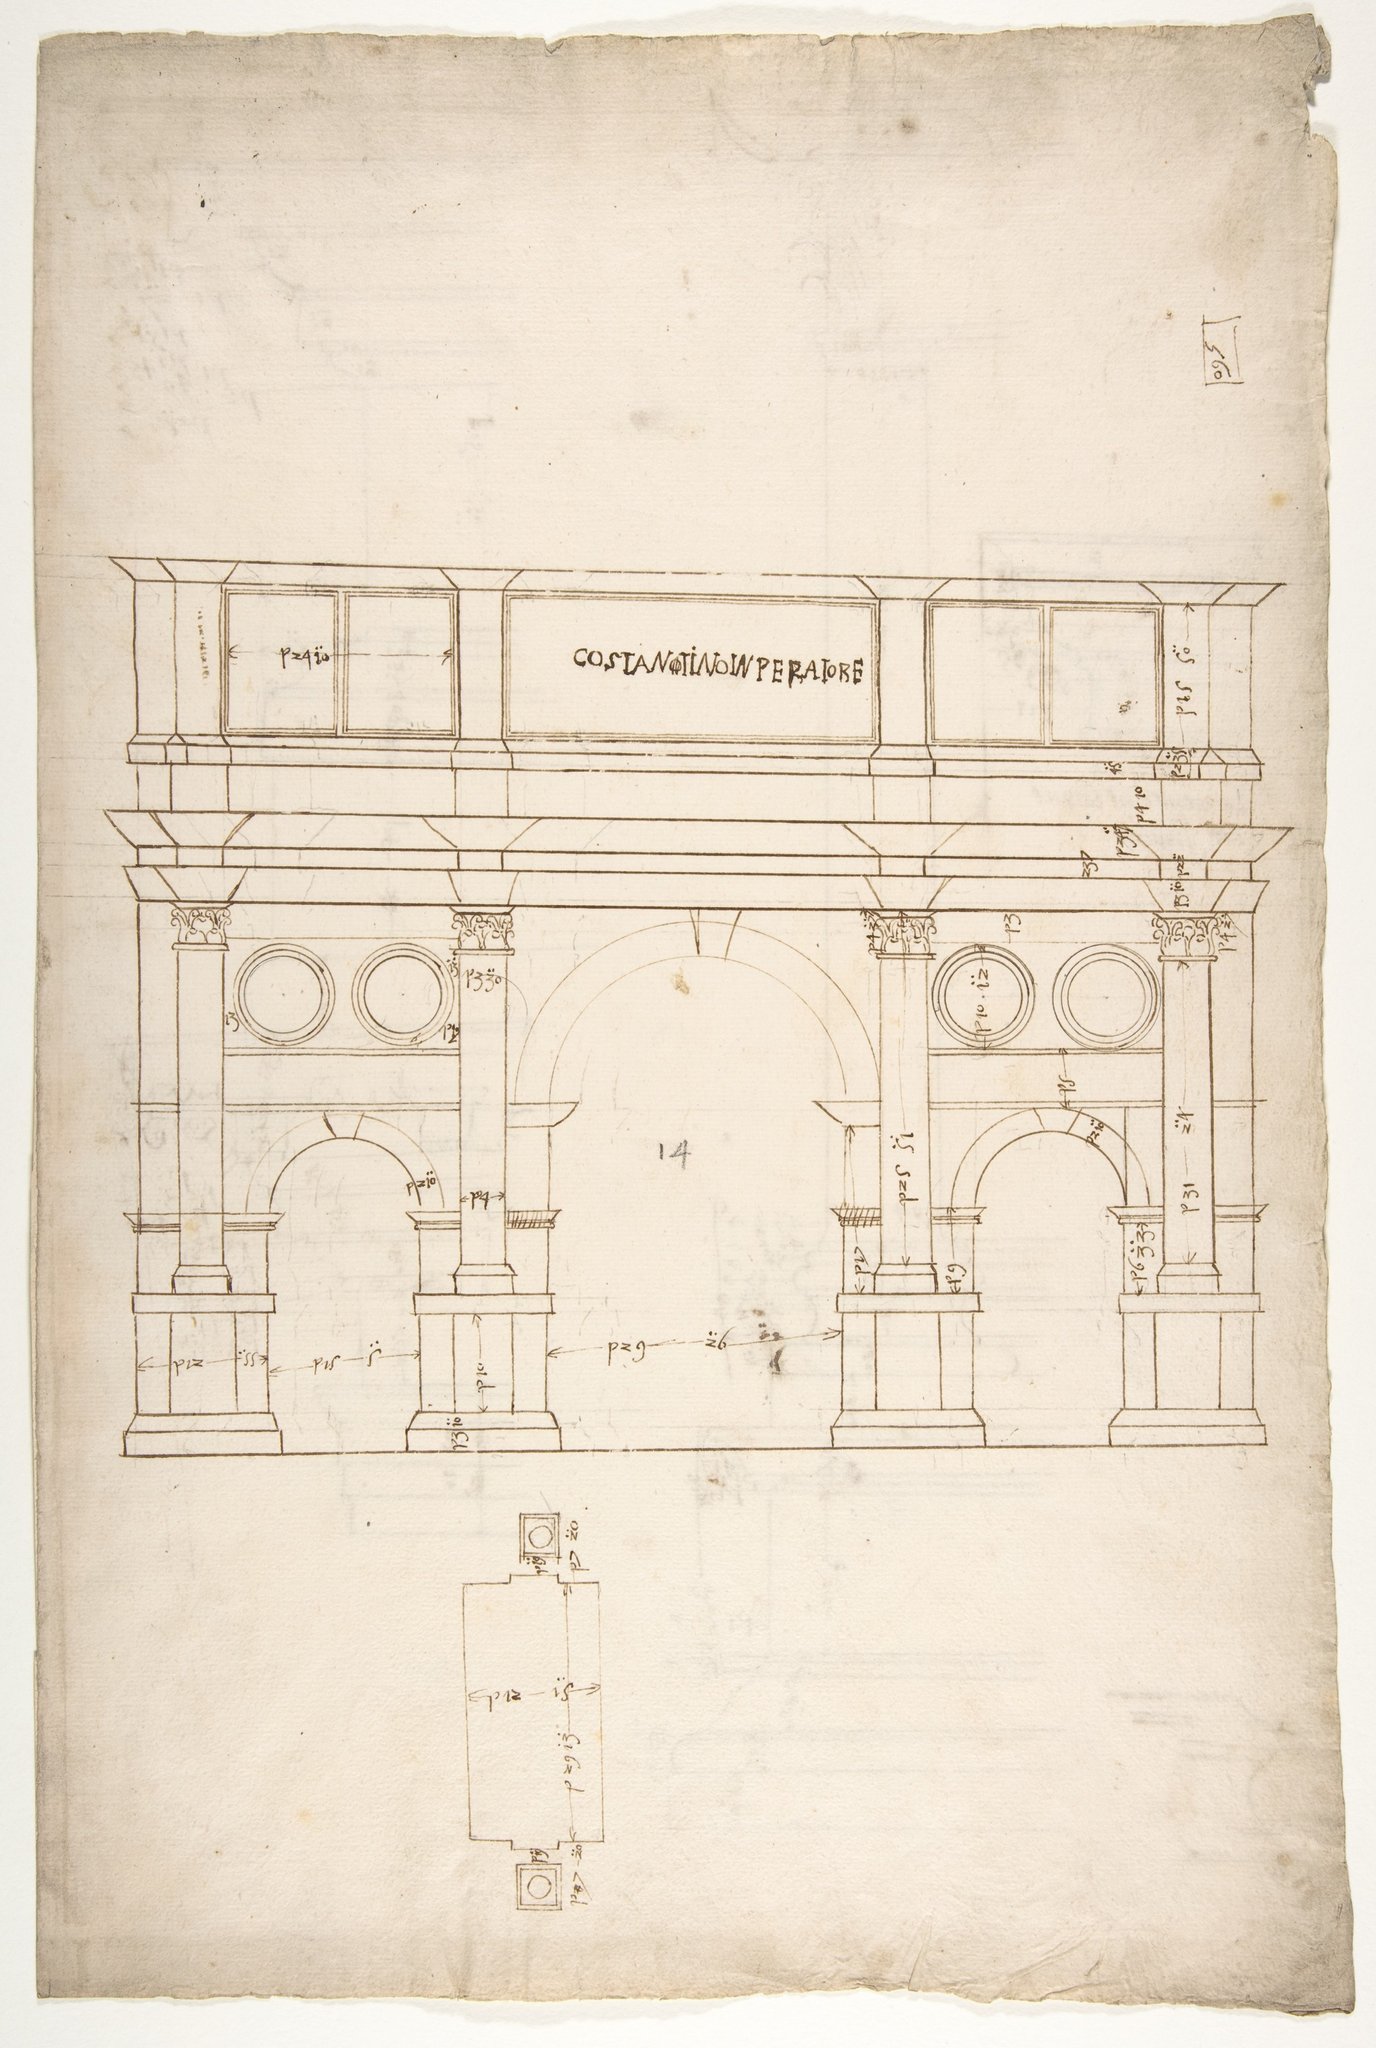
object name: collection ornament architecture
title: Arch of Constantine, elev, partial plan (recto) Arch of Constantine, profiles of base, shaft and entablature (verso)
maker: anonymous, french, 16th century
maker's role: draftsman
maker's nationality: french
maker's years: 1500-1600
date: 1540-1560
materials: chalk, ink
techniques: incising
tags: architecture,arches